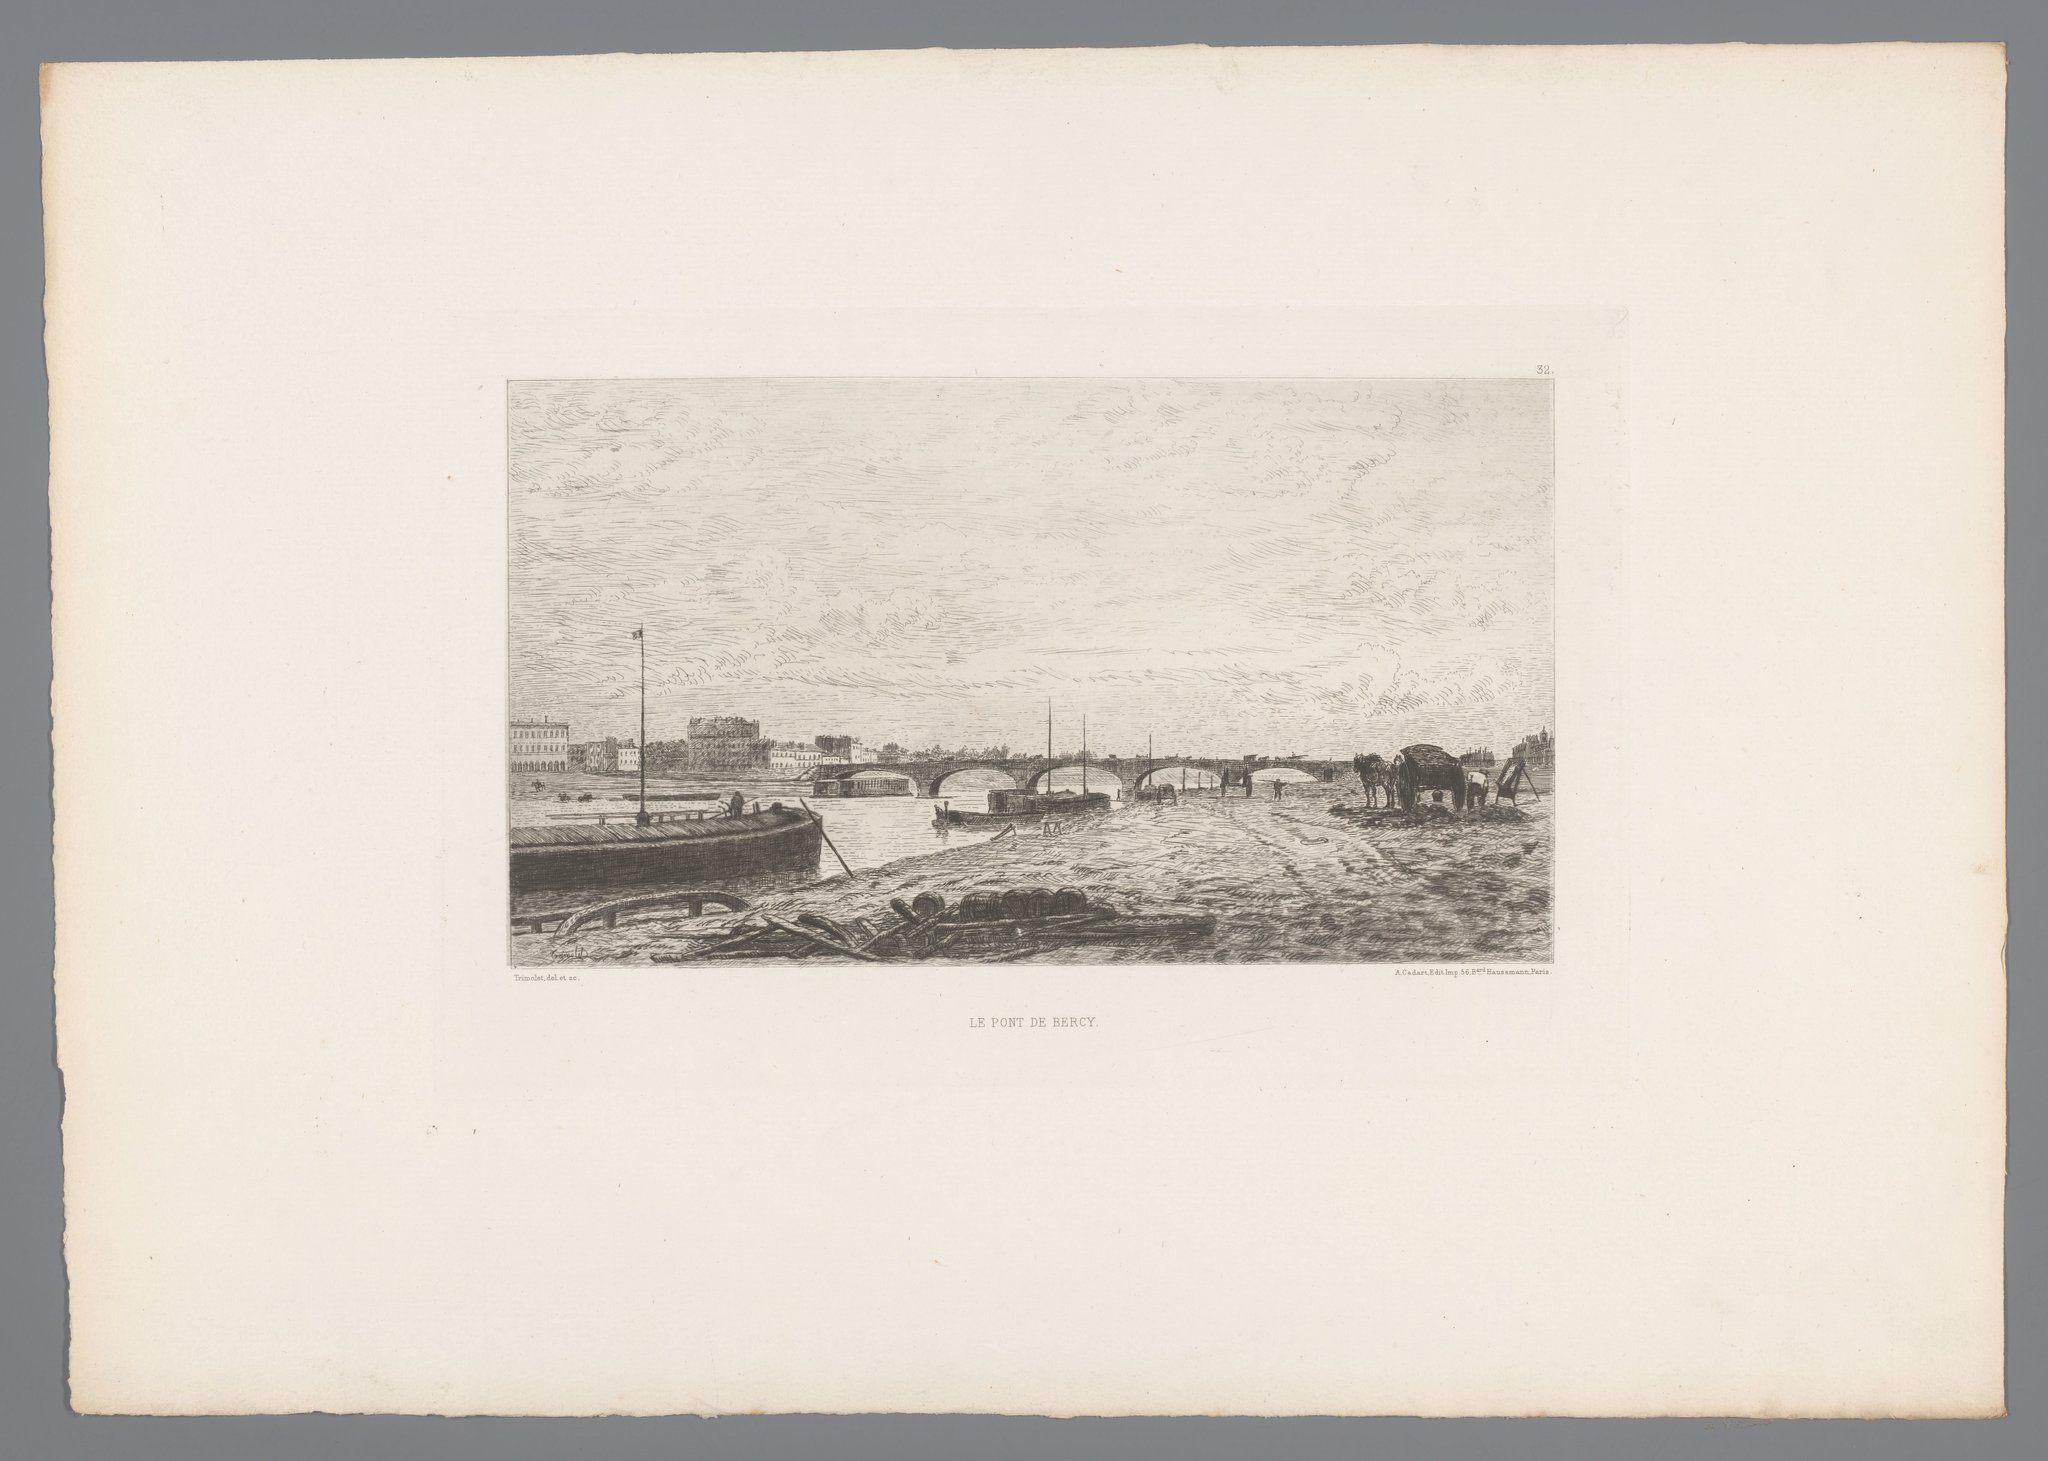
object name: print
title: Franse etsen uit 1875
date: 1875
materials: paper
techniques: drypoint, etching, intaglio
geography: paris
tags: bridge, paris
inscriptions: collector's mark: ‘AFE v S’, collector's mark: Lugt 2228, collector's mark: Lugt 2760